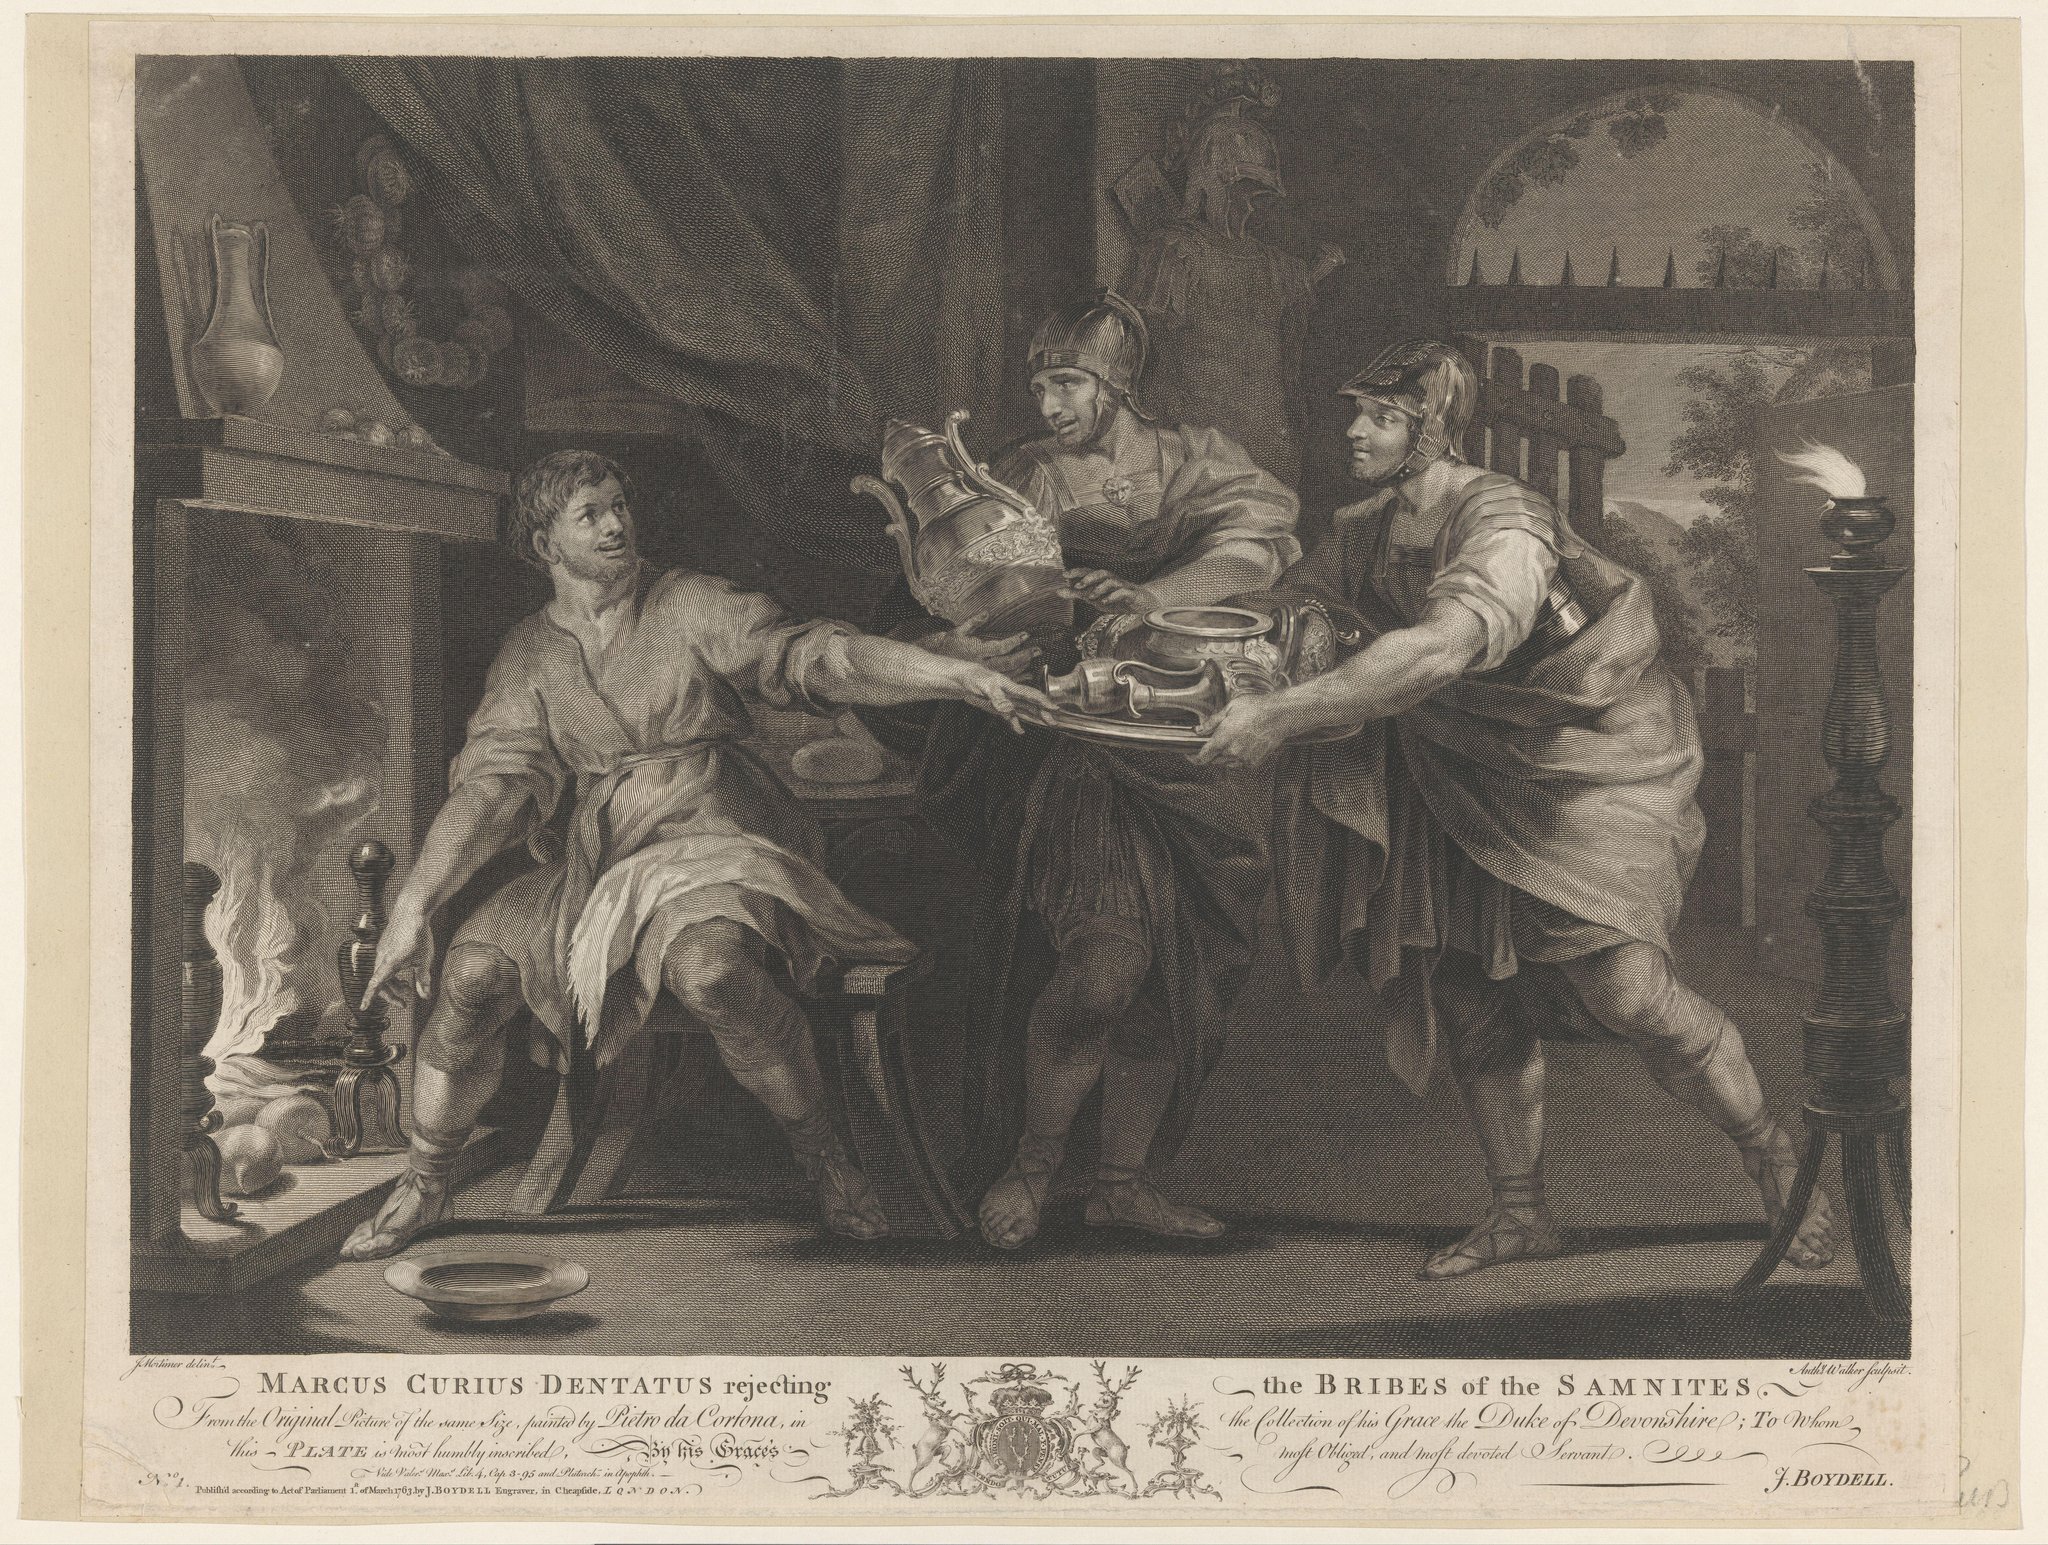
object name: print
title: Marcus Curius Dentatus rejecting the bribes of the Samnites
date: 1763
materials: paper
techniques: engraving, etching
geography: london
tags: manius curius dentatus, while cooking a simple meal at his hearth, refuses the gifts of the samnites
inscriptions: collector's mark: Lugt 240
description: Consul Manius Curius Dentatus weigert de kostbare geschenken van de Samnieten en verkiest zijn eenvoudige maal van geroosterde rapen, ca. 270-290 v.Chr.